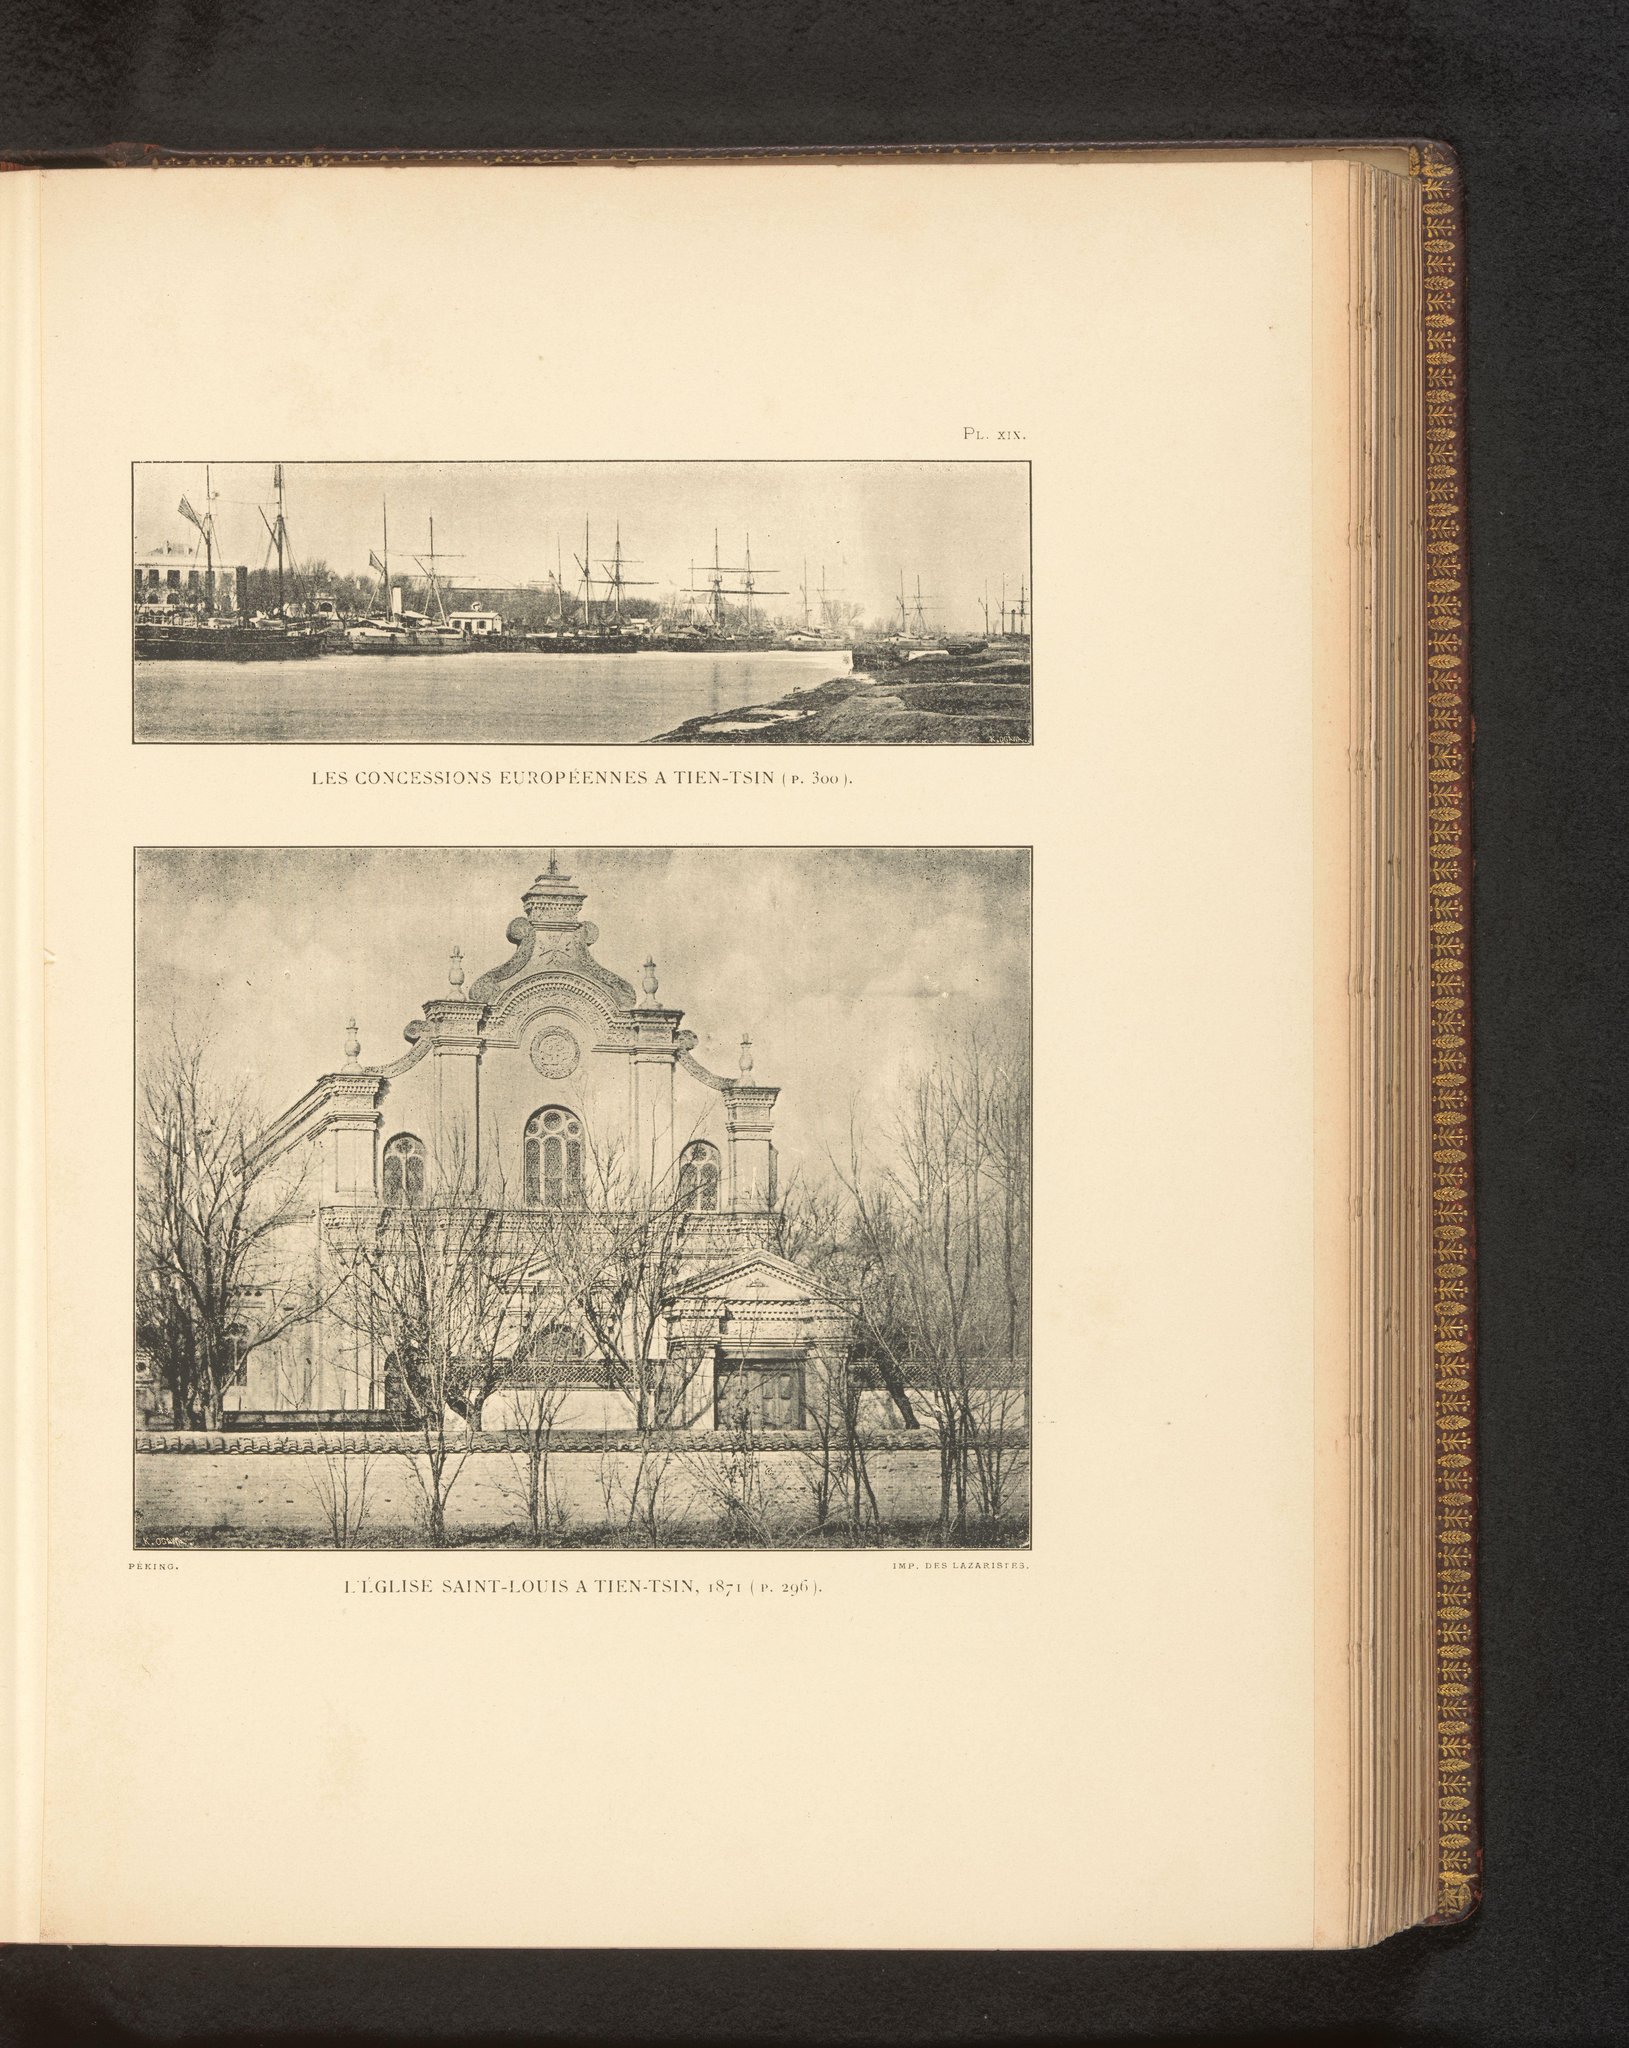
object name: page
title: Gezicht op meerdere zeilboten te water en Gezicht op een kerk te Tianjin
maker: Anonymous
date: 1892-1897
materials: paper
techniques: autotype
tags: sailing-ship, sailing-boat, landscapes with waters, waterscapes, seascapes (in the temperate zone), church (exterior)